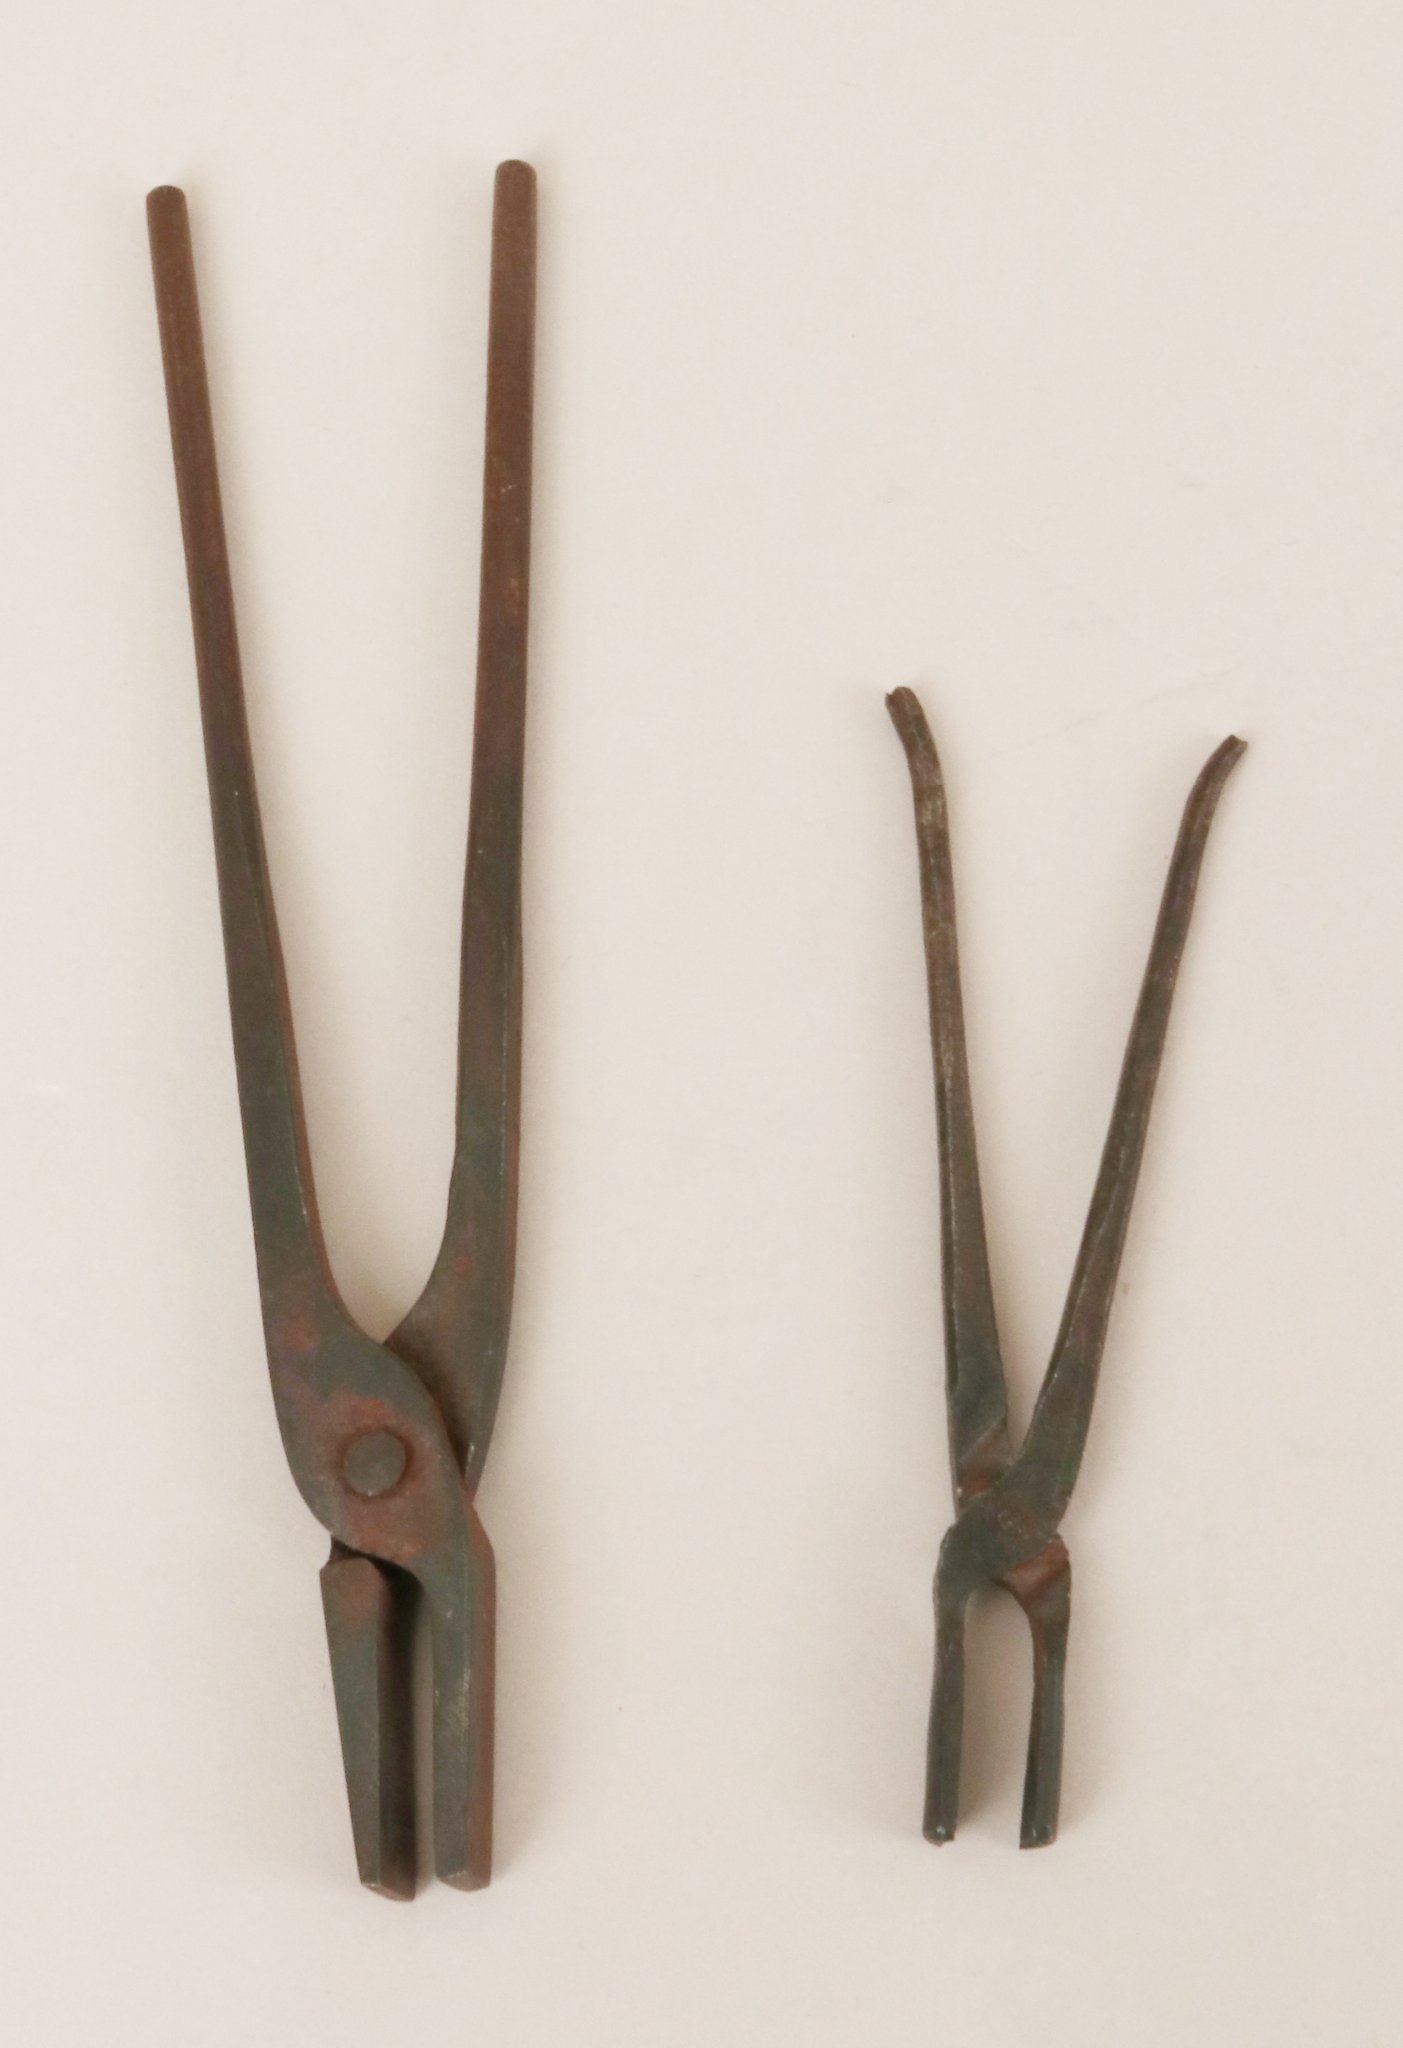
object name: crèche accessory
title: Two pairs of tongs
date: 1701-1800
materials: iron